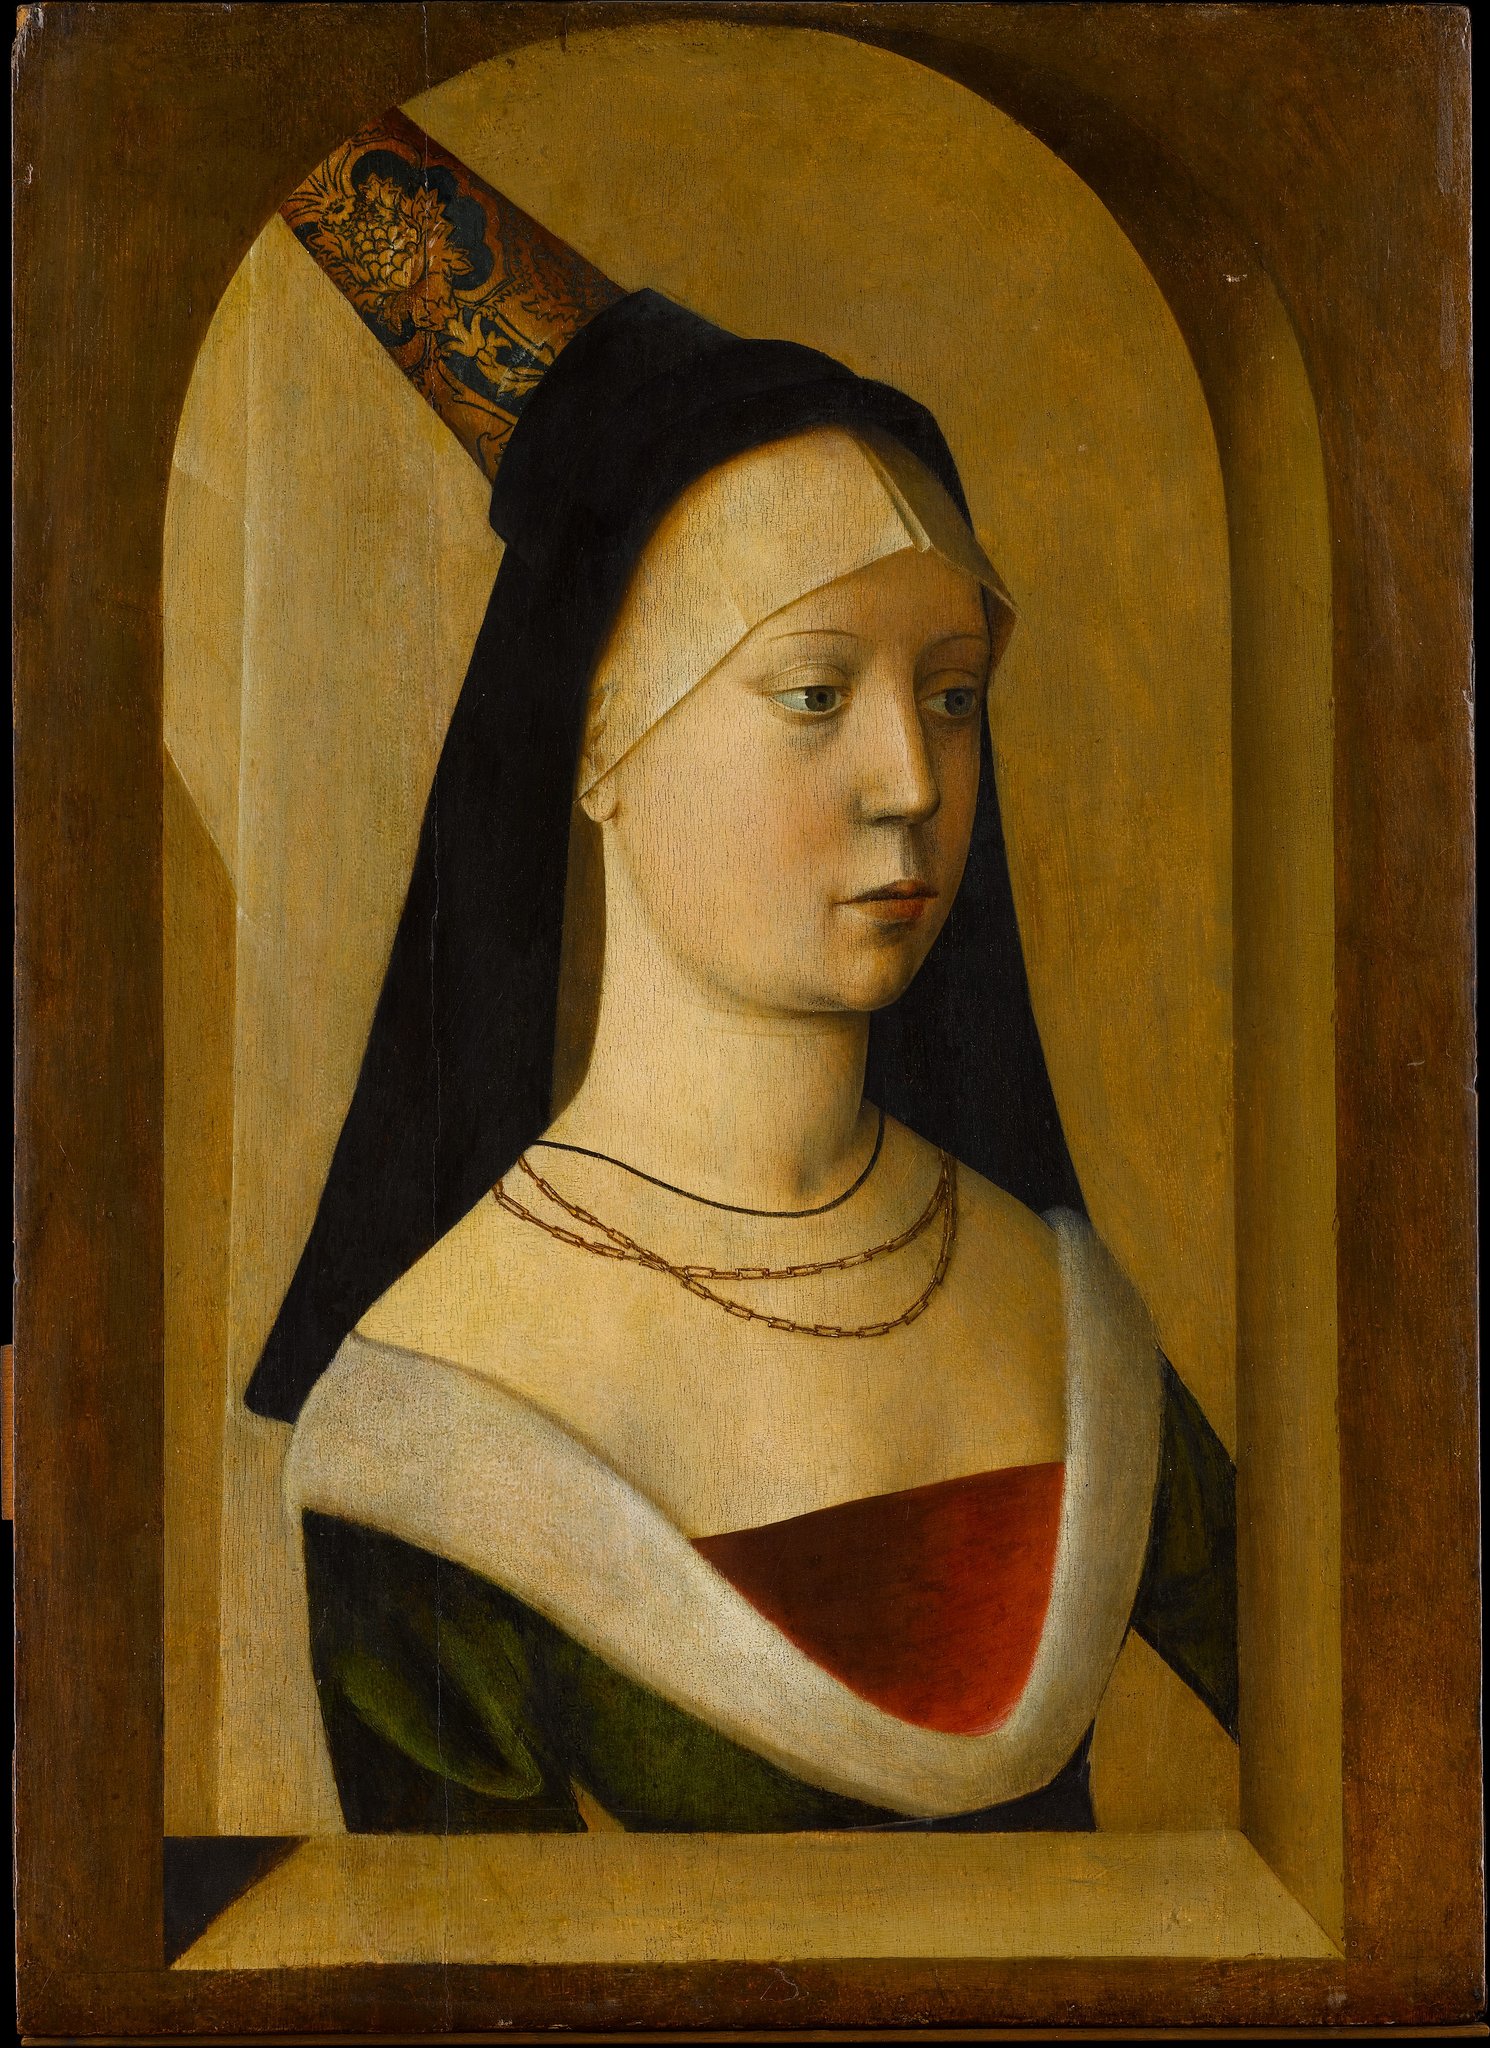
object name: painting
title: Portrait of a Woman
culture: franco-flemish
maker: netherlandish or french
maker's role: artist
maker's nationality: netherlandish or french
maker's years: 1475-1480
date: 1470-1480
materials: wood, oil, panel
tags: portraits,women